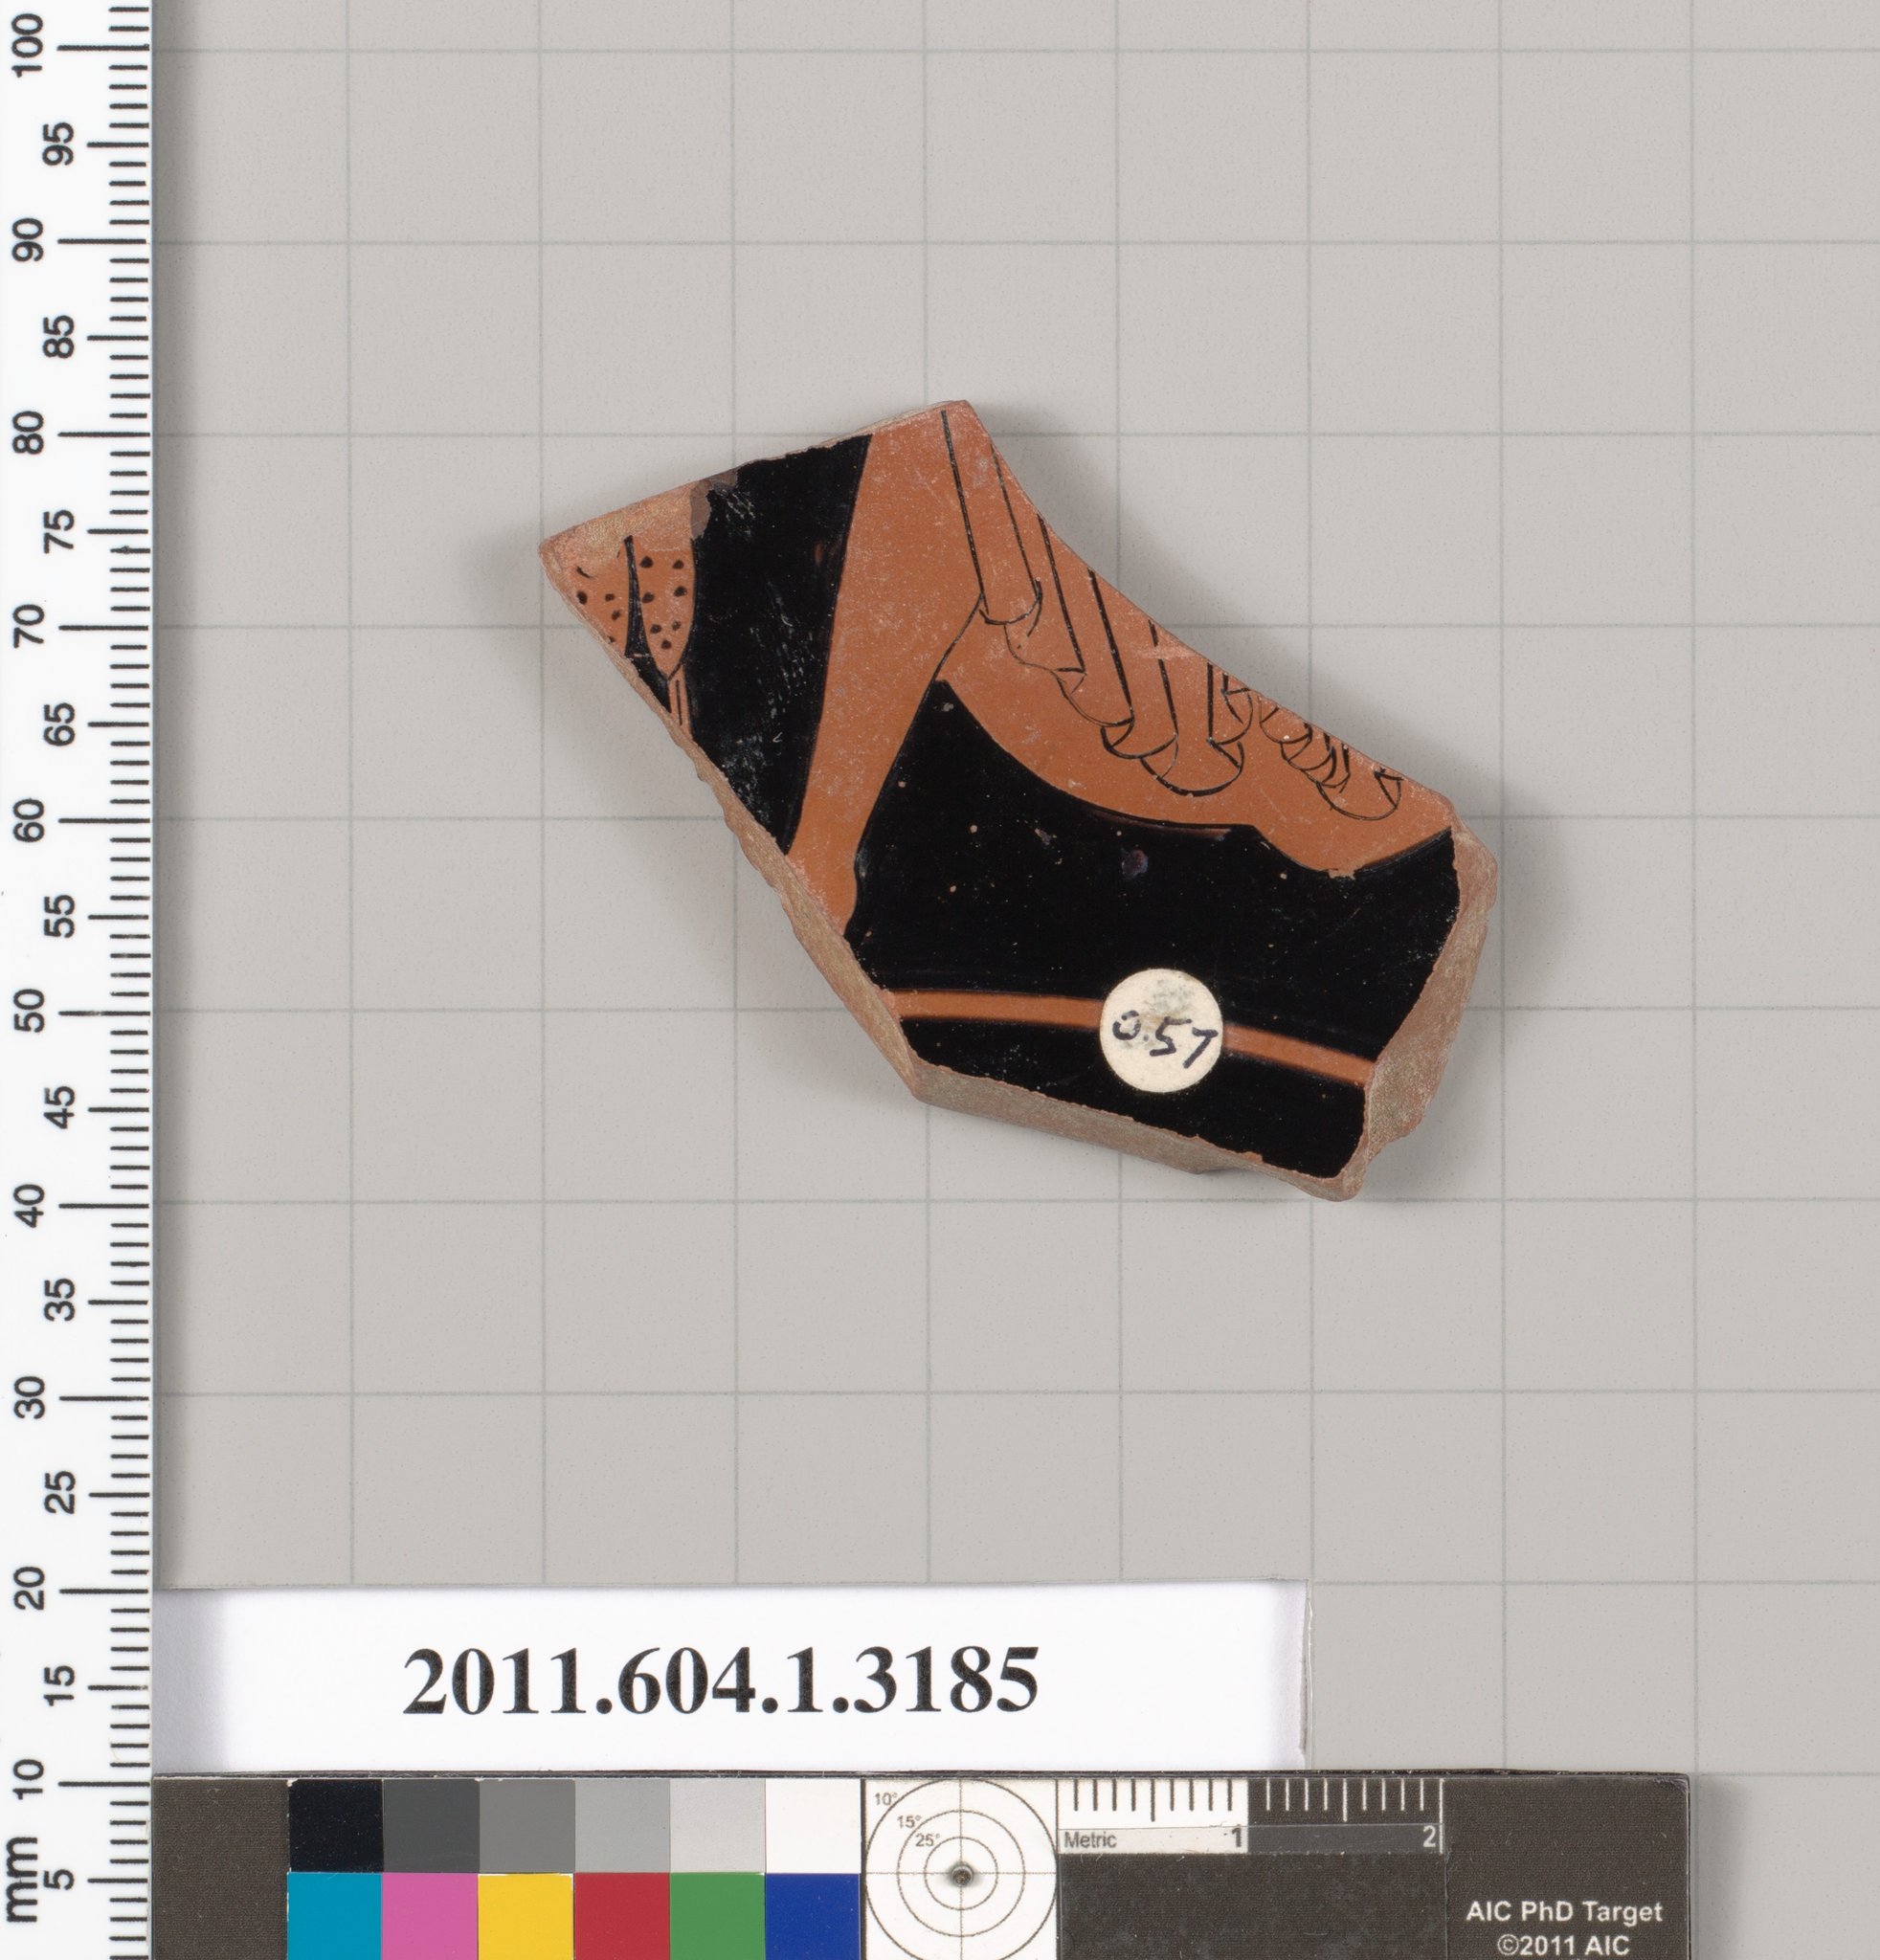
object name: kylix fragment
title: Terracotta fragment of a kylix (drinking cup)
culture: greek, attic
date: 510-490 BCE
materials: terracotta